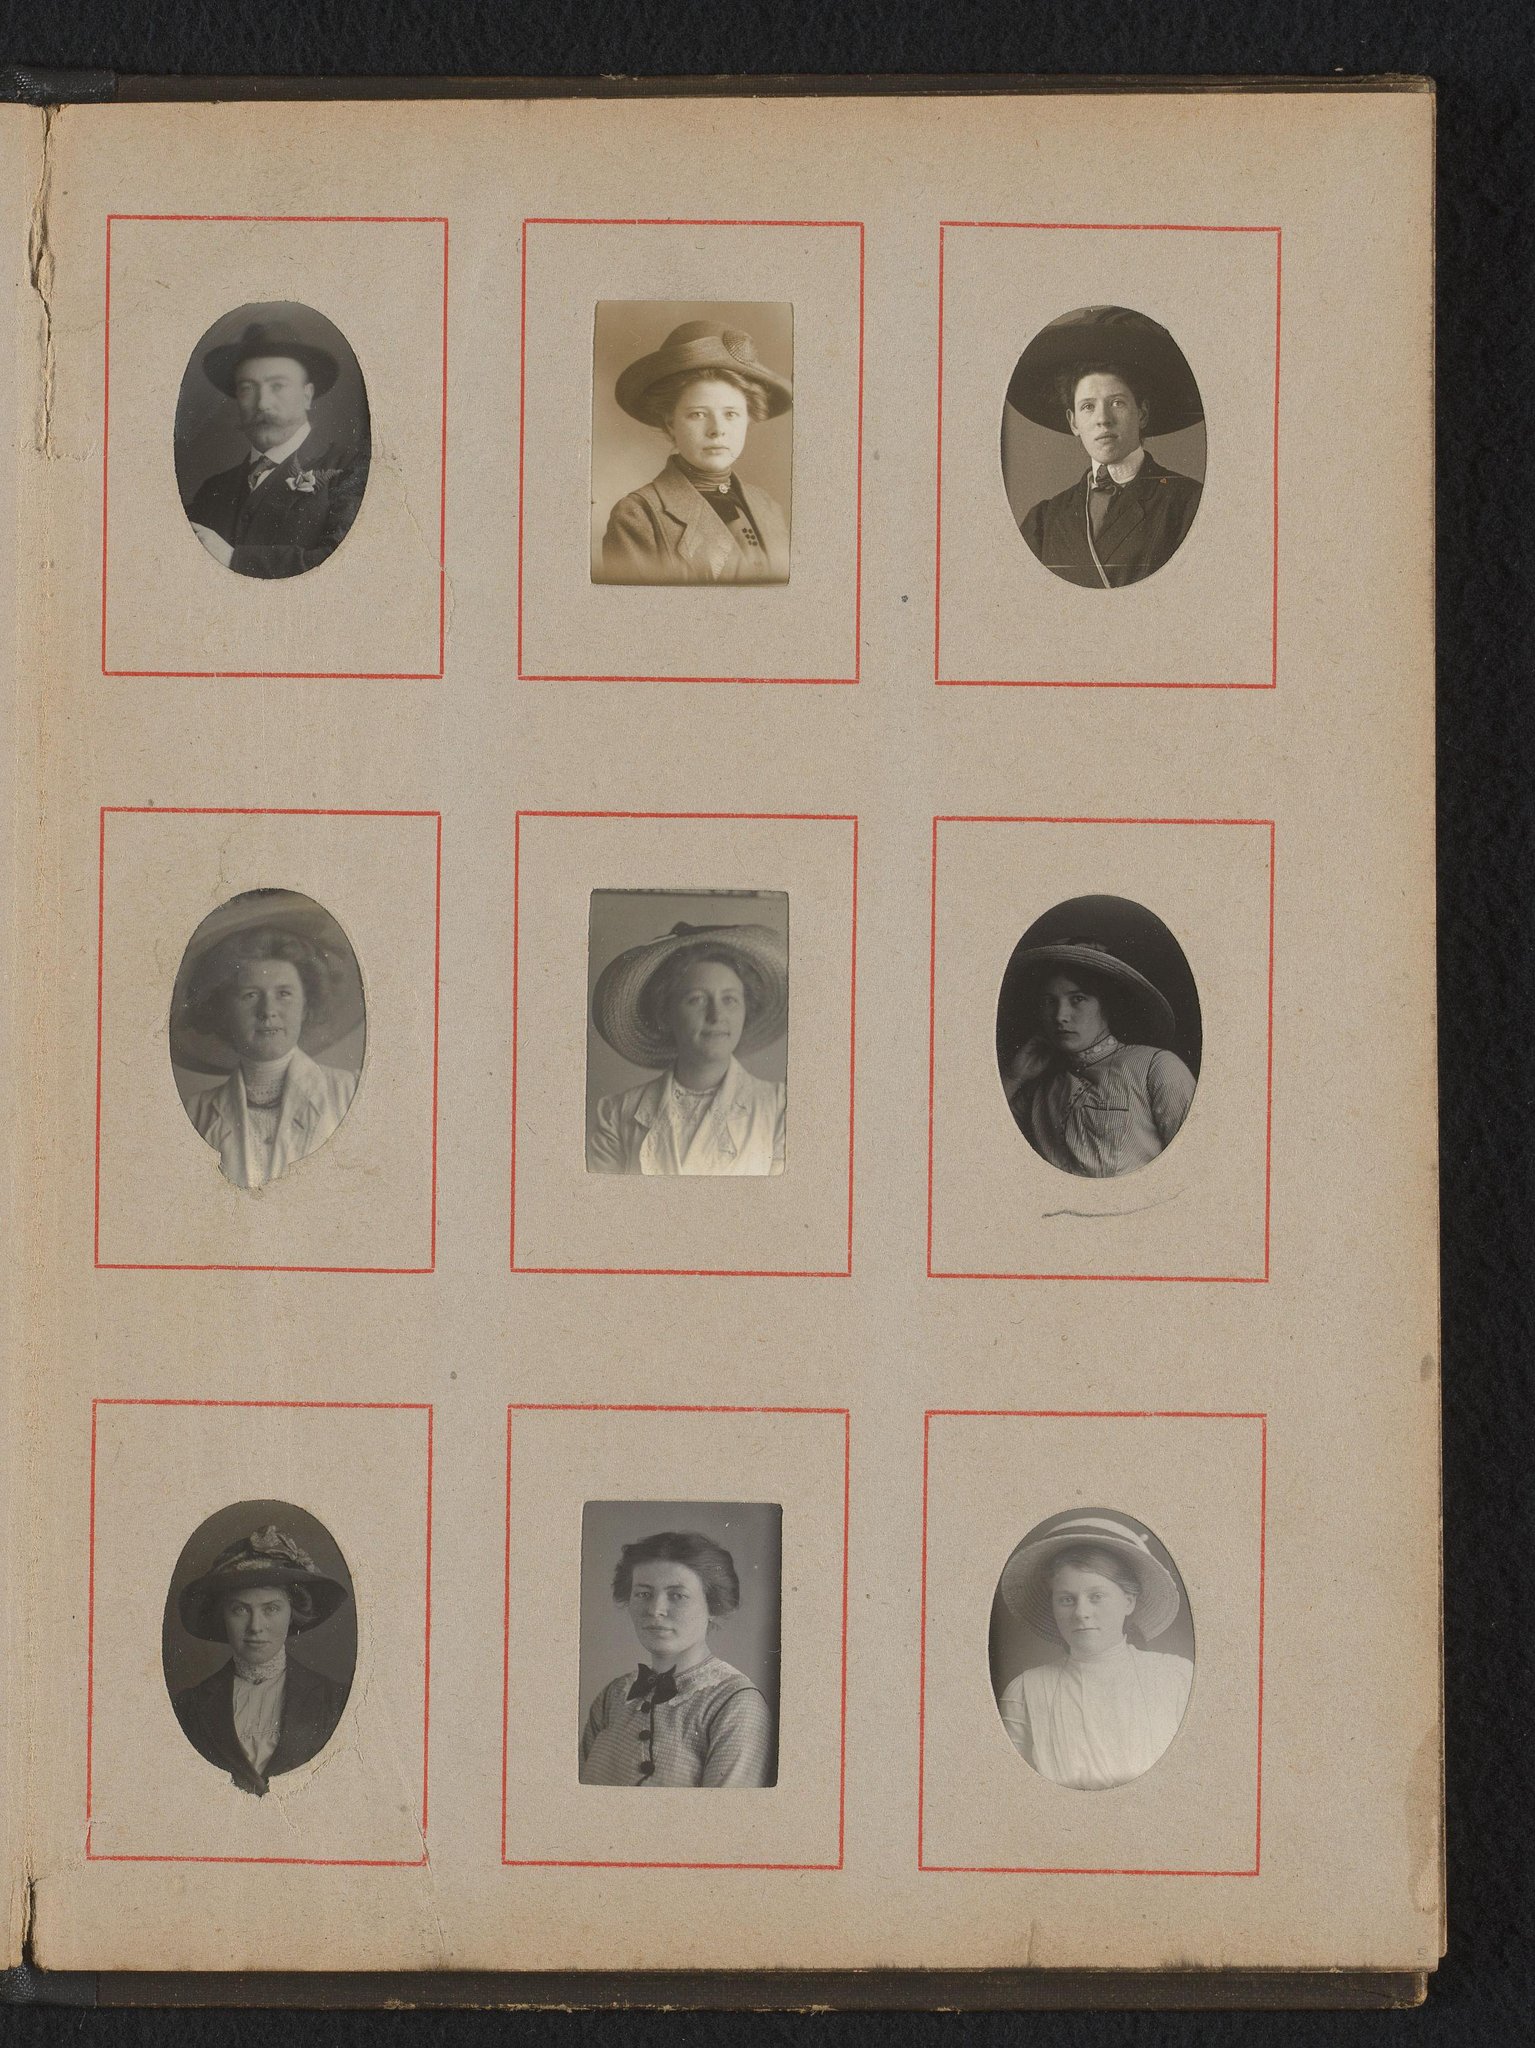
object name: snapshot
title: Zeven portretten van jonge vrouwen en twee portretten van mannen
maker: Anonymous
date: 1900-1920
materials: cardboard, paper, photographic support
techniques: gelatin silver print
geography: netherlands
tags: historical persons - bb - woman, moustache, historical persons, head-gear: hat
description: Deze foto's maken deel uit van een album.